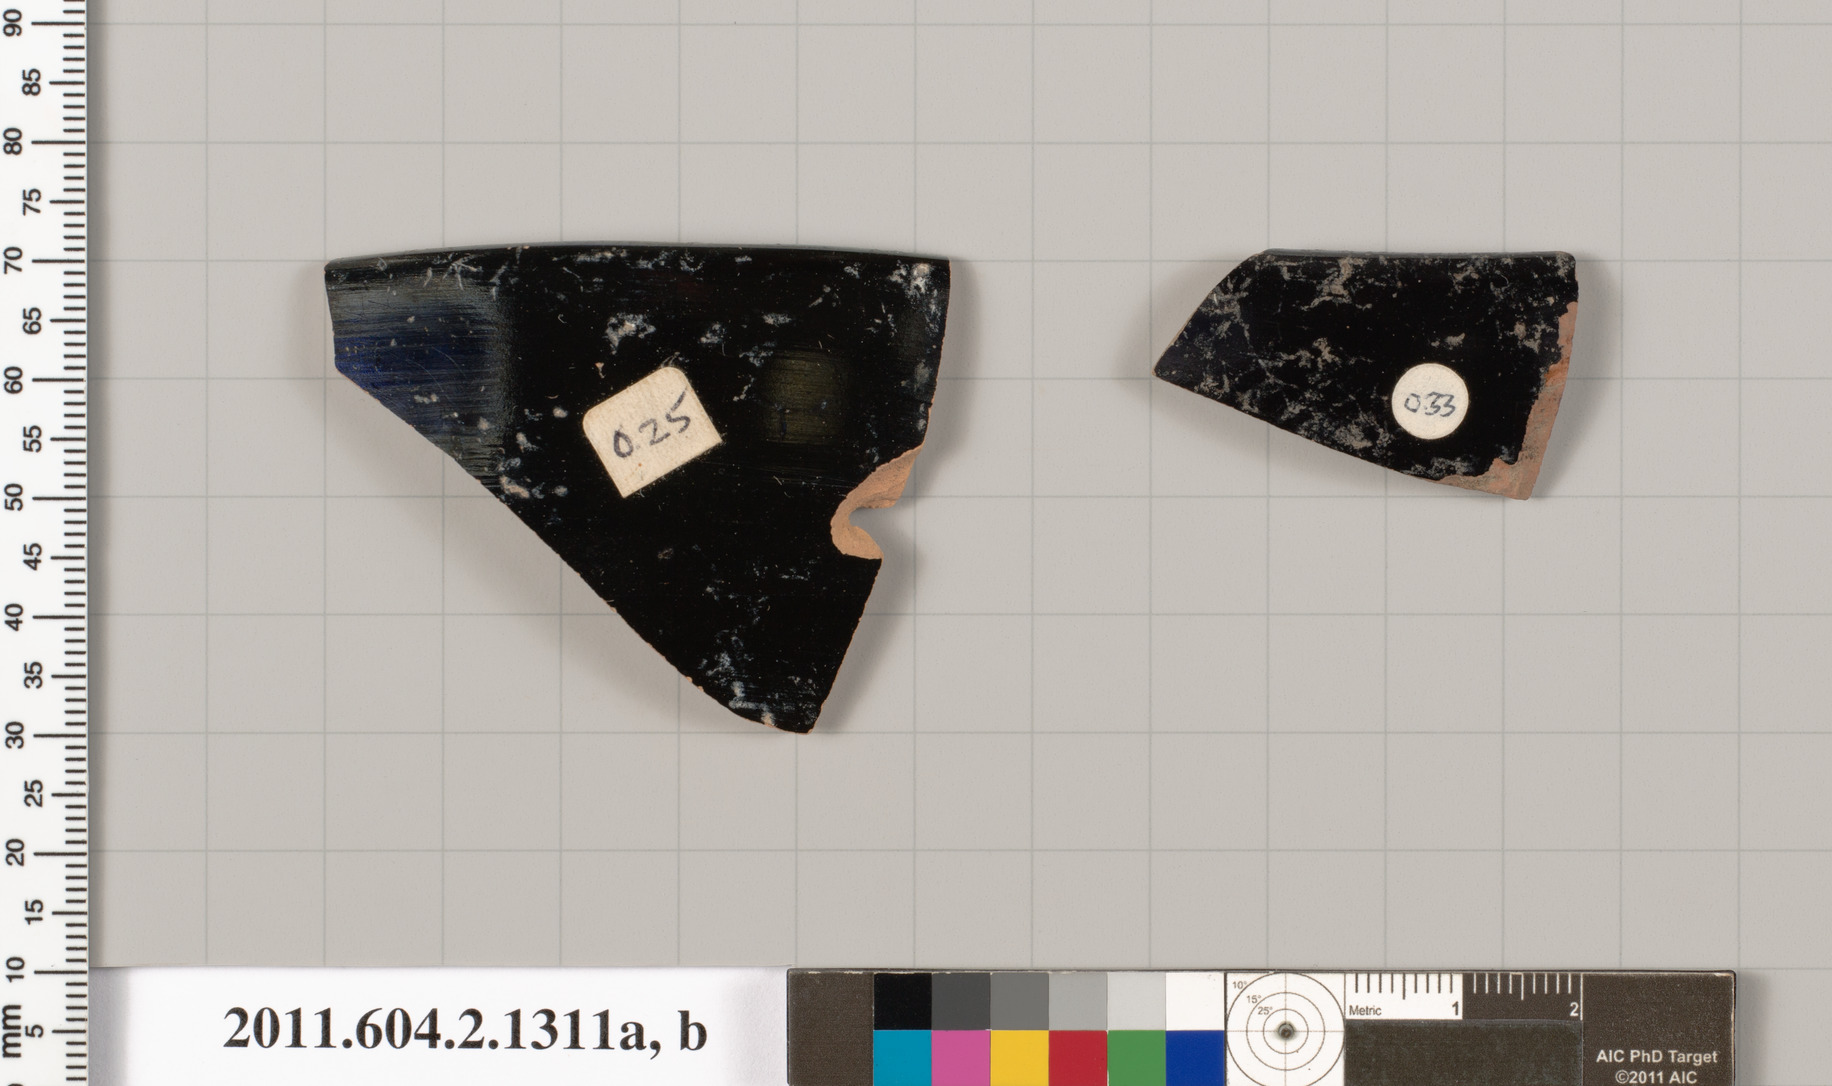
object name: skyphos fragment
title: Terracotta rim fragments of skyphoi (deep drinking cups)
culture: greek, attic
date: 600-401 BCE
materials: terracotta